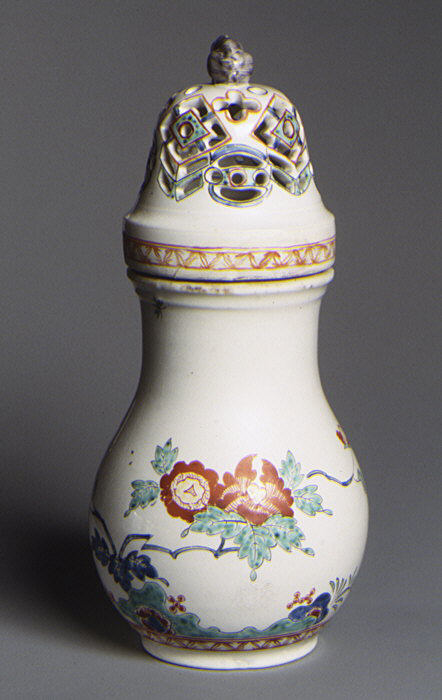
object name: caster with cover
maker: chantilly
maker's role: factory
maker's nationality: french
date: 1735-1740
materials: soft paste porcelain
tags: flowers